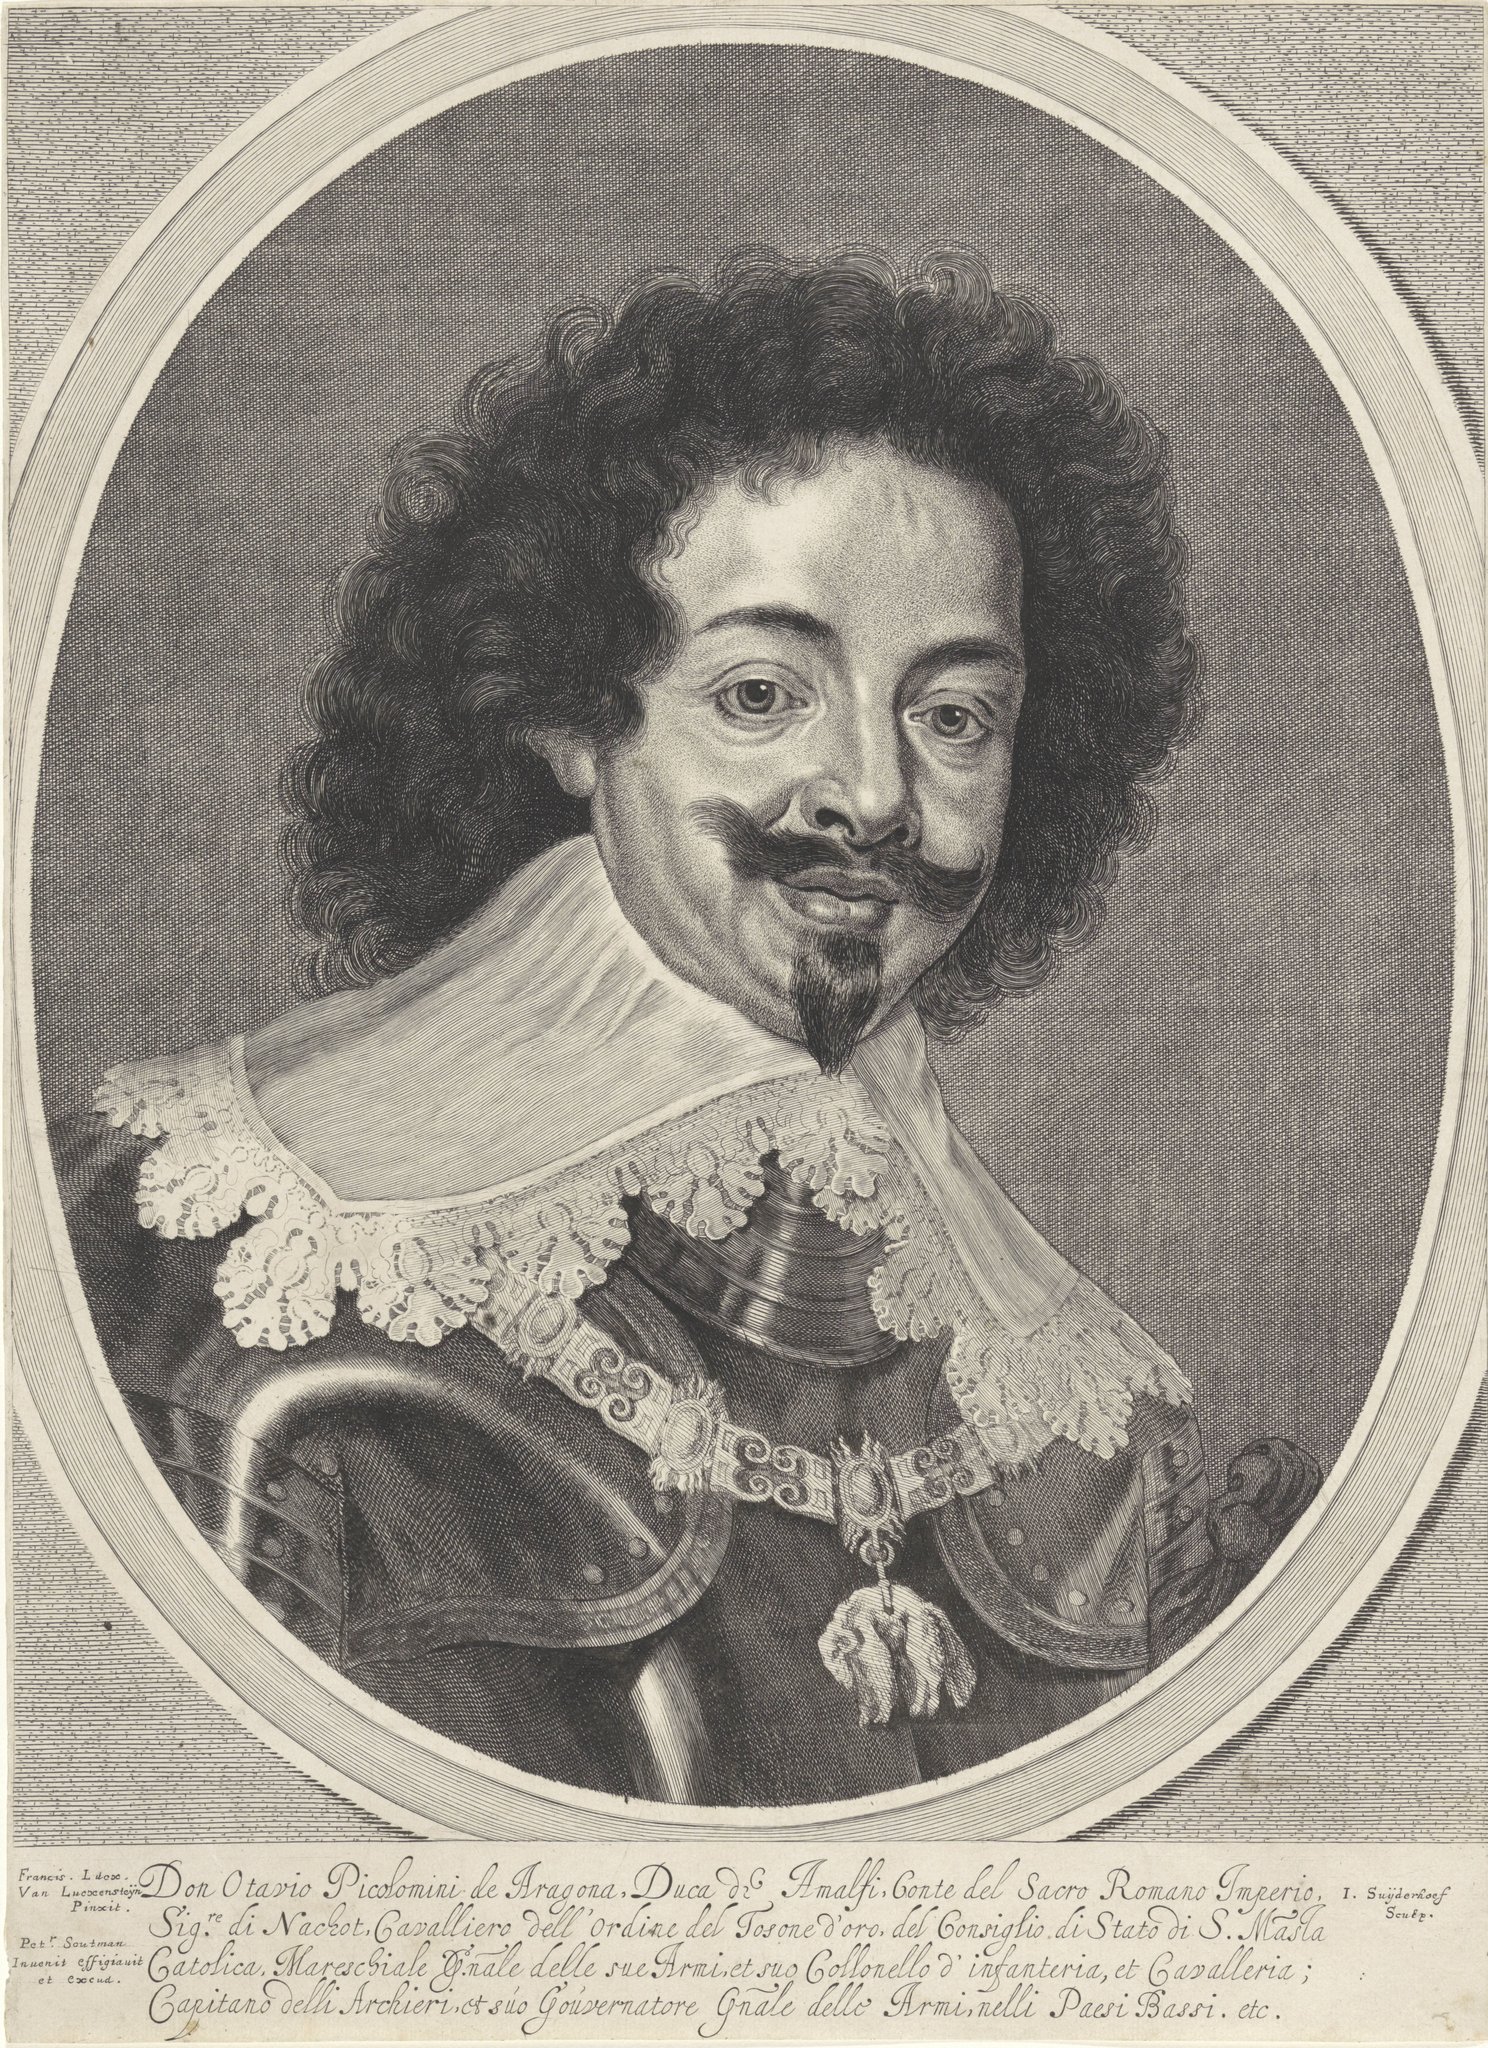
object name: print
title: Portret van Ottavio Piccolomini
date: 1644-1650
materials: paper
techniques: engraving, etching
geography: haarlem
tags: historical persons, knighthood order of the golden fleece - insignia of a knighthood order, e.g.: badge, chain (with name of order)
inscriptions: collector's mark: Lugt 240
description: Portret van Ottavio Picolomini, hertog van Amalfi en veldmaarschalk van het Heilig Roomse Rijk, met een ketting met het ordeteken van de Orde van het Gulden Vlies op zijn borst. Onderaan in de marge een vierregelige tekst in het Italiaans.